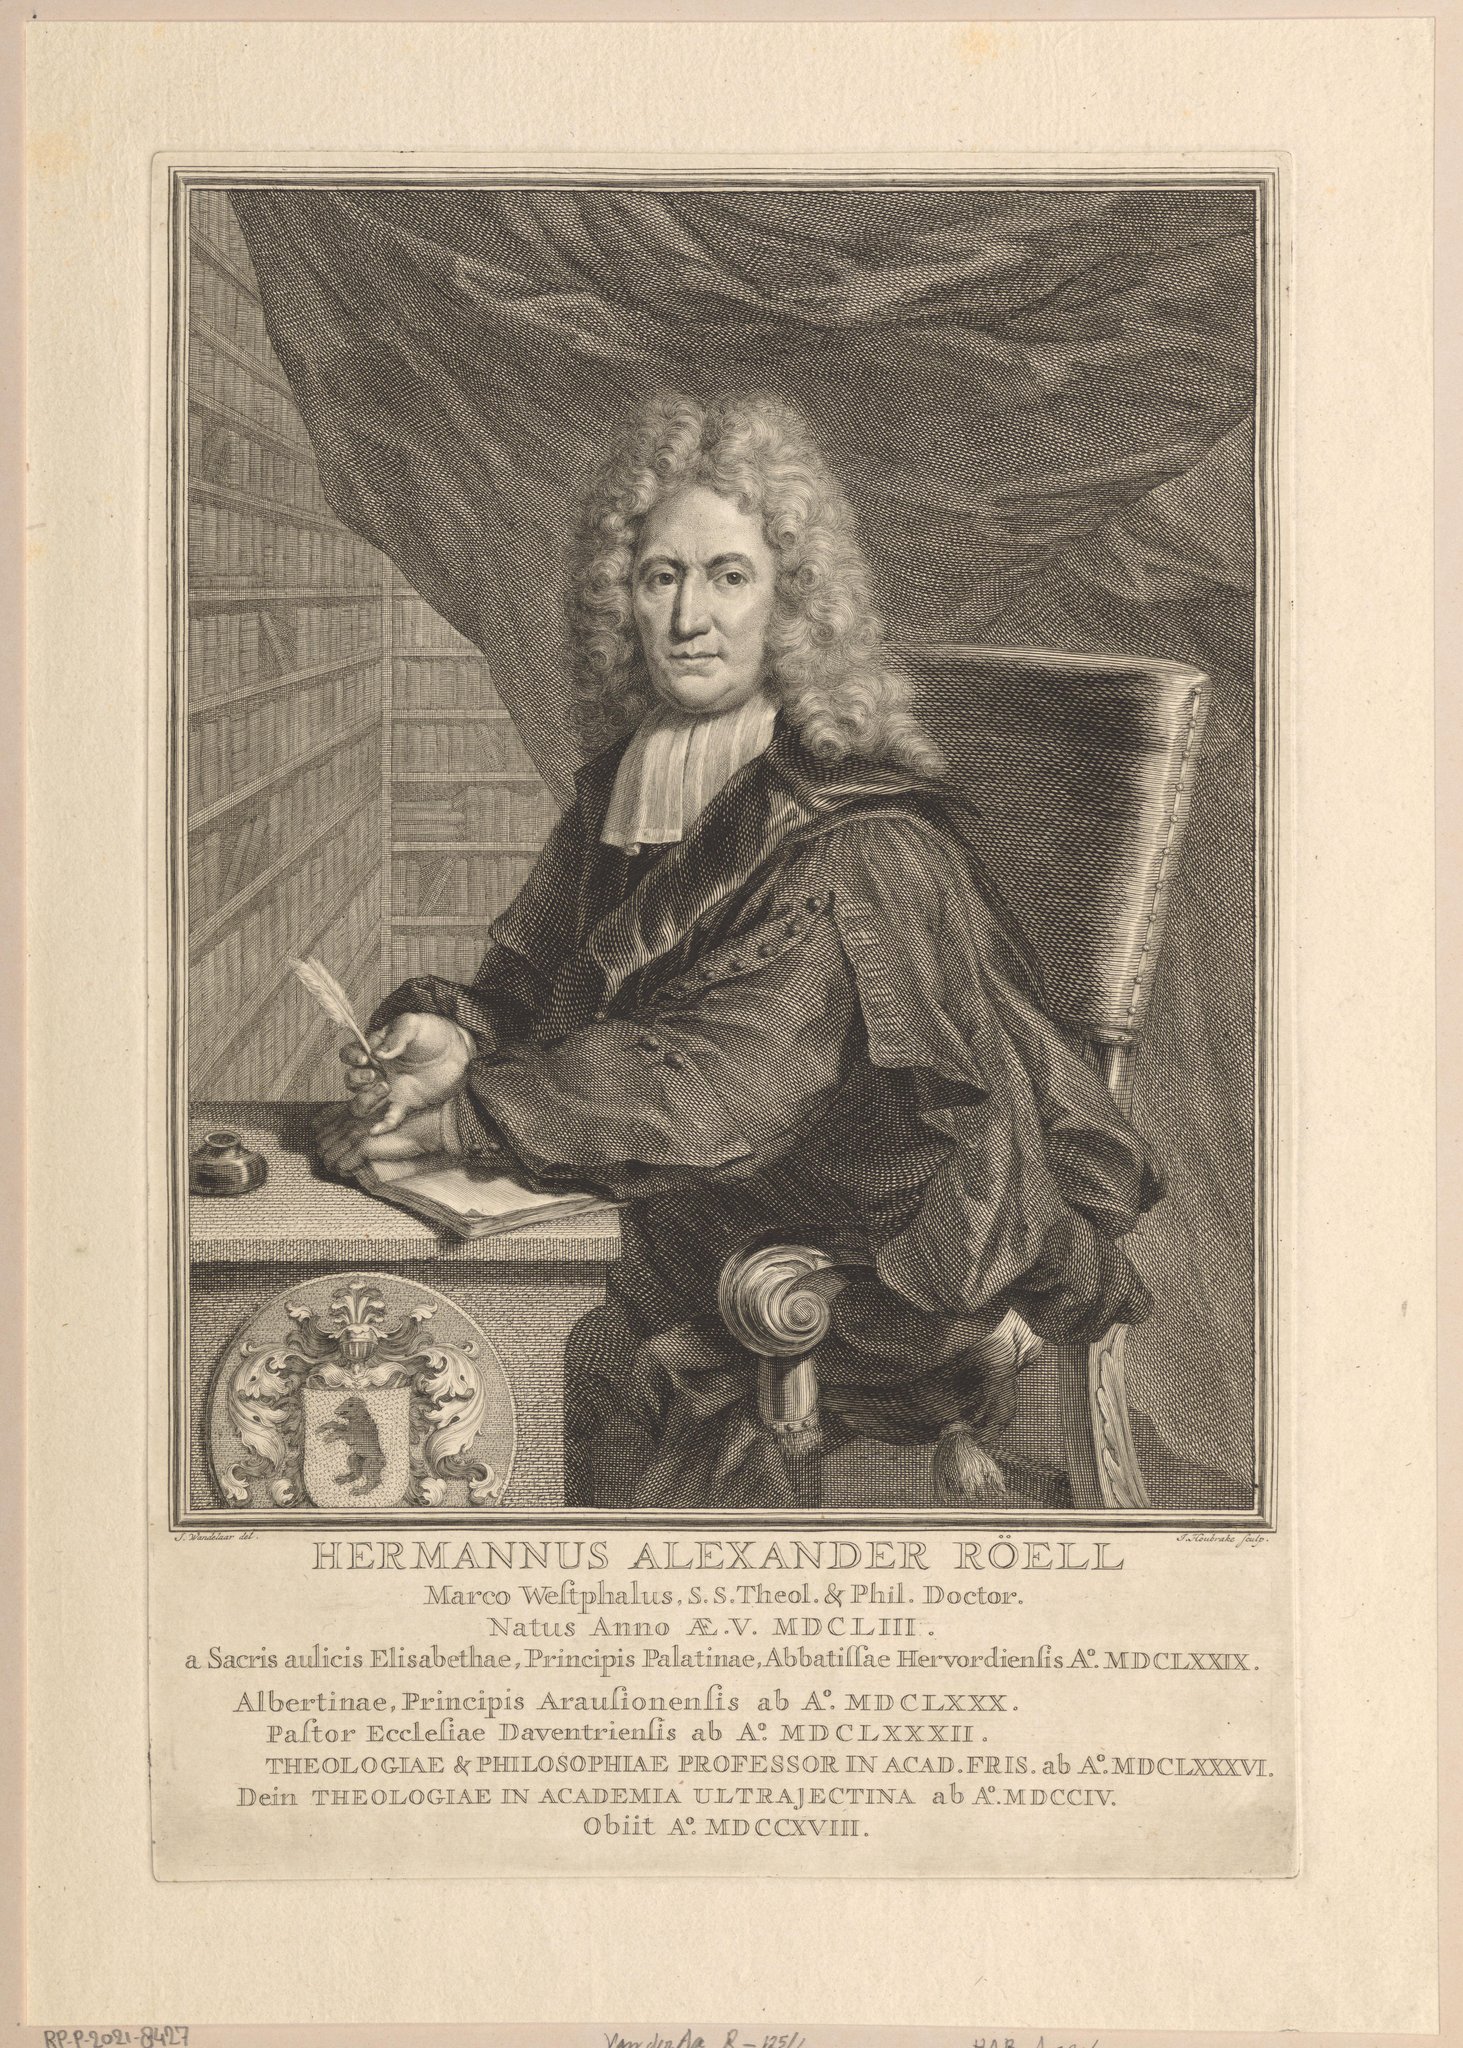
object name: print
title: Portret van Herman Alexander Roëll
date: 1718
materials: paper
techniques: engraving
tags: sitting figure, historical persons, book, armorial bearing, heraldry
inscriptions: date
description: Onder het portret zijn wapenschild. Onder het portret zijn biografie in het Latijn.